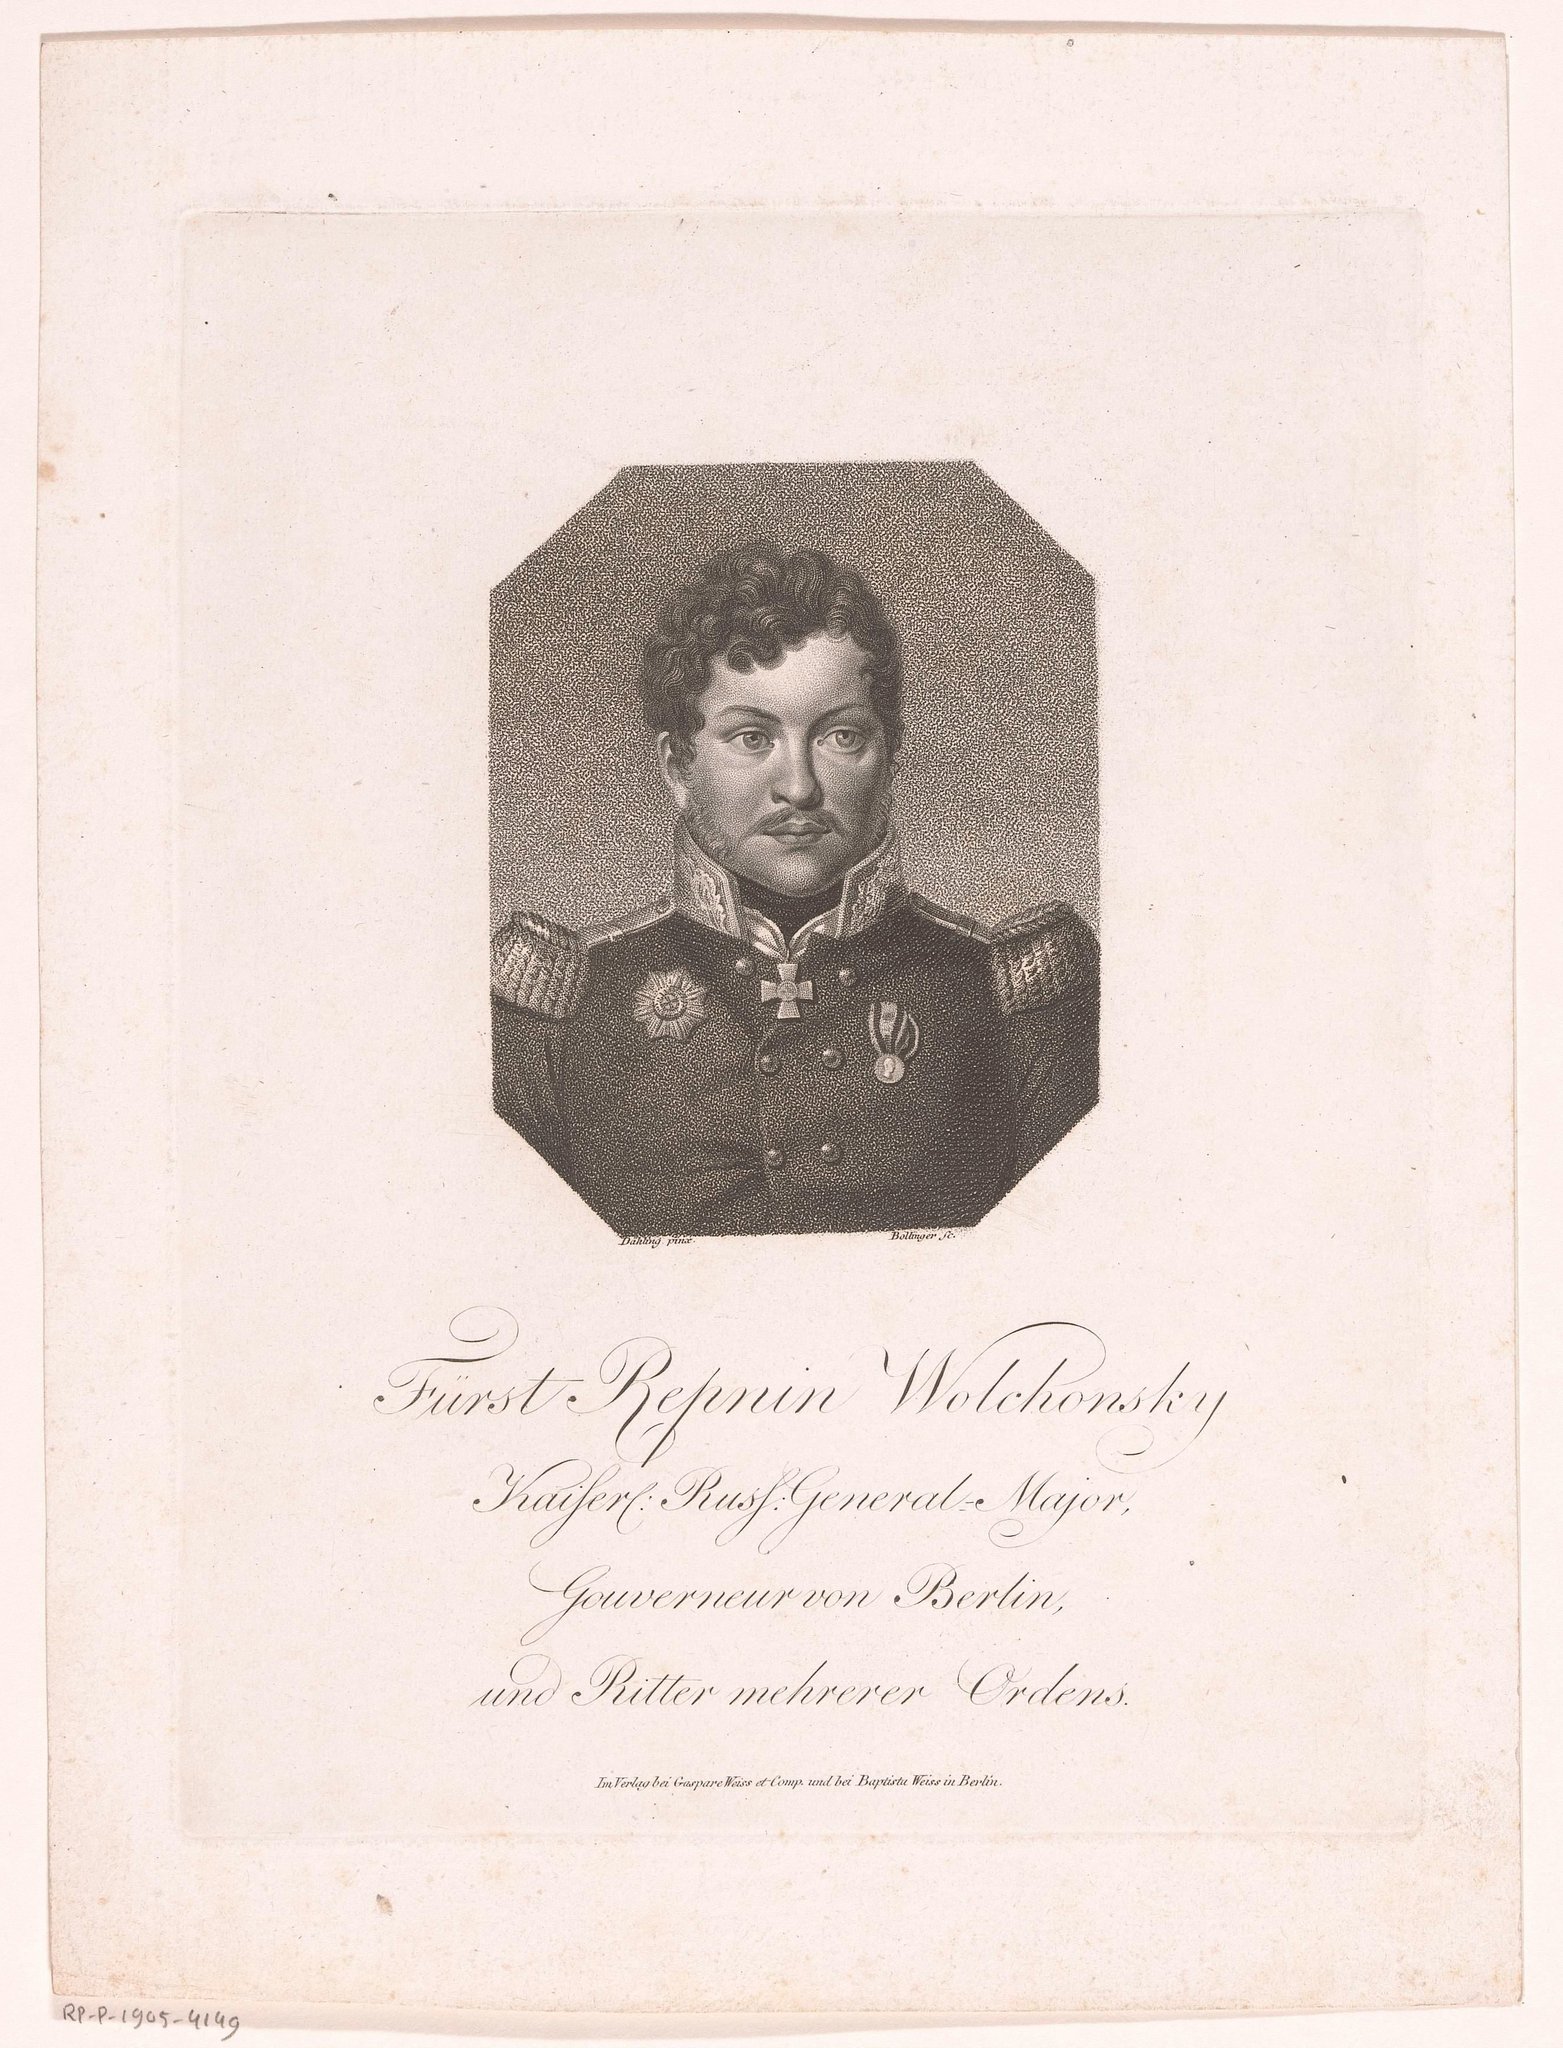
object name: print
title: Portret van Nikolai Grigorjewitsch Repnin-Wolkonski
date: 1813-1825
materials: paper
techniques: stippling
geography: berlin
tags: russia, knighthood order, historical persons, (military) uniforms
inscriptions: collector's mark: Lugt 2228